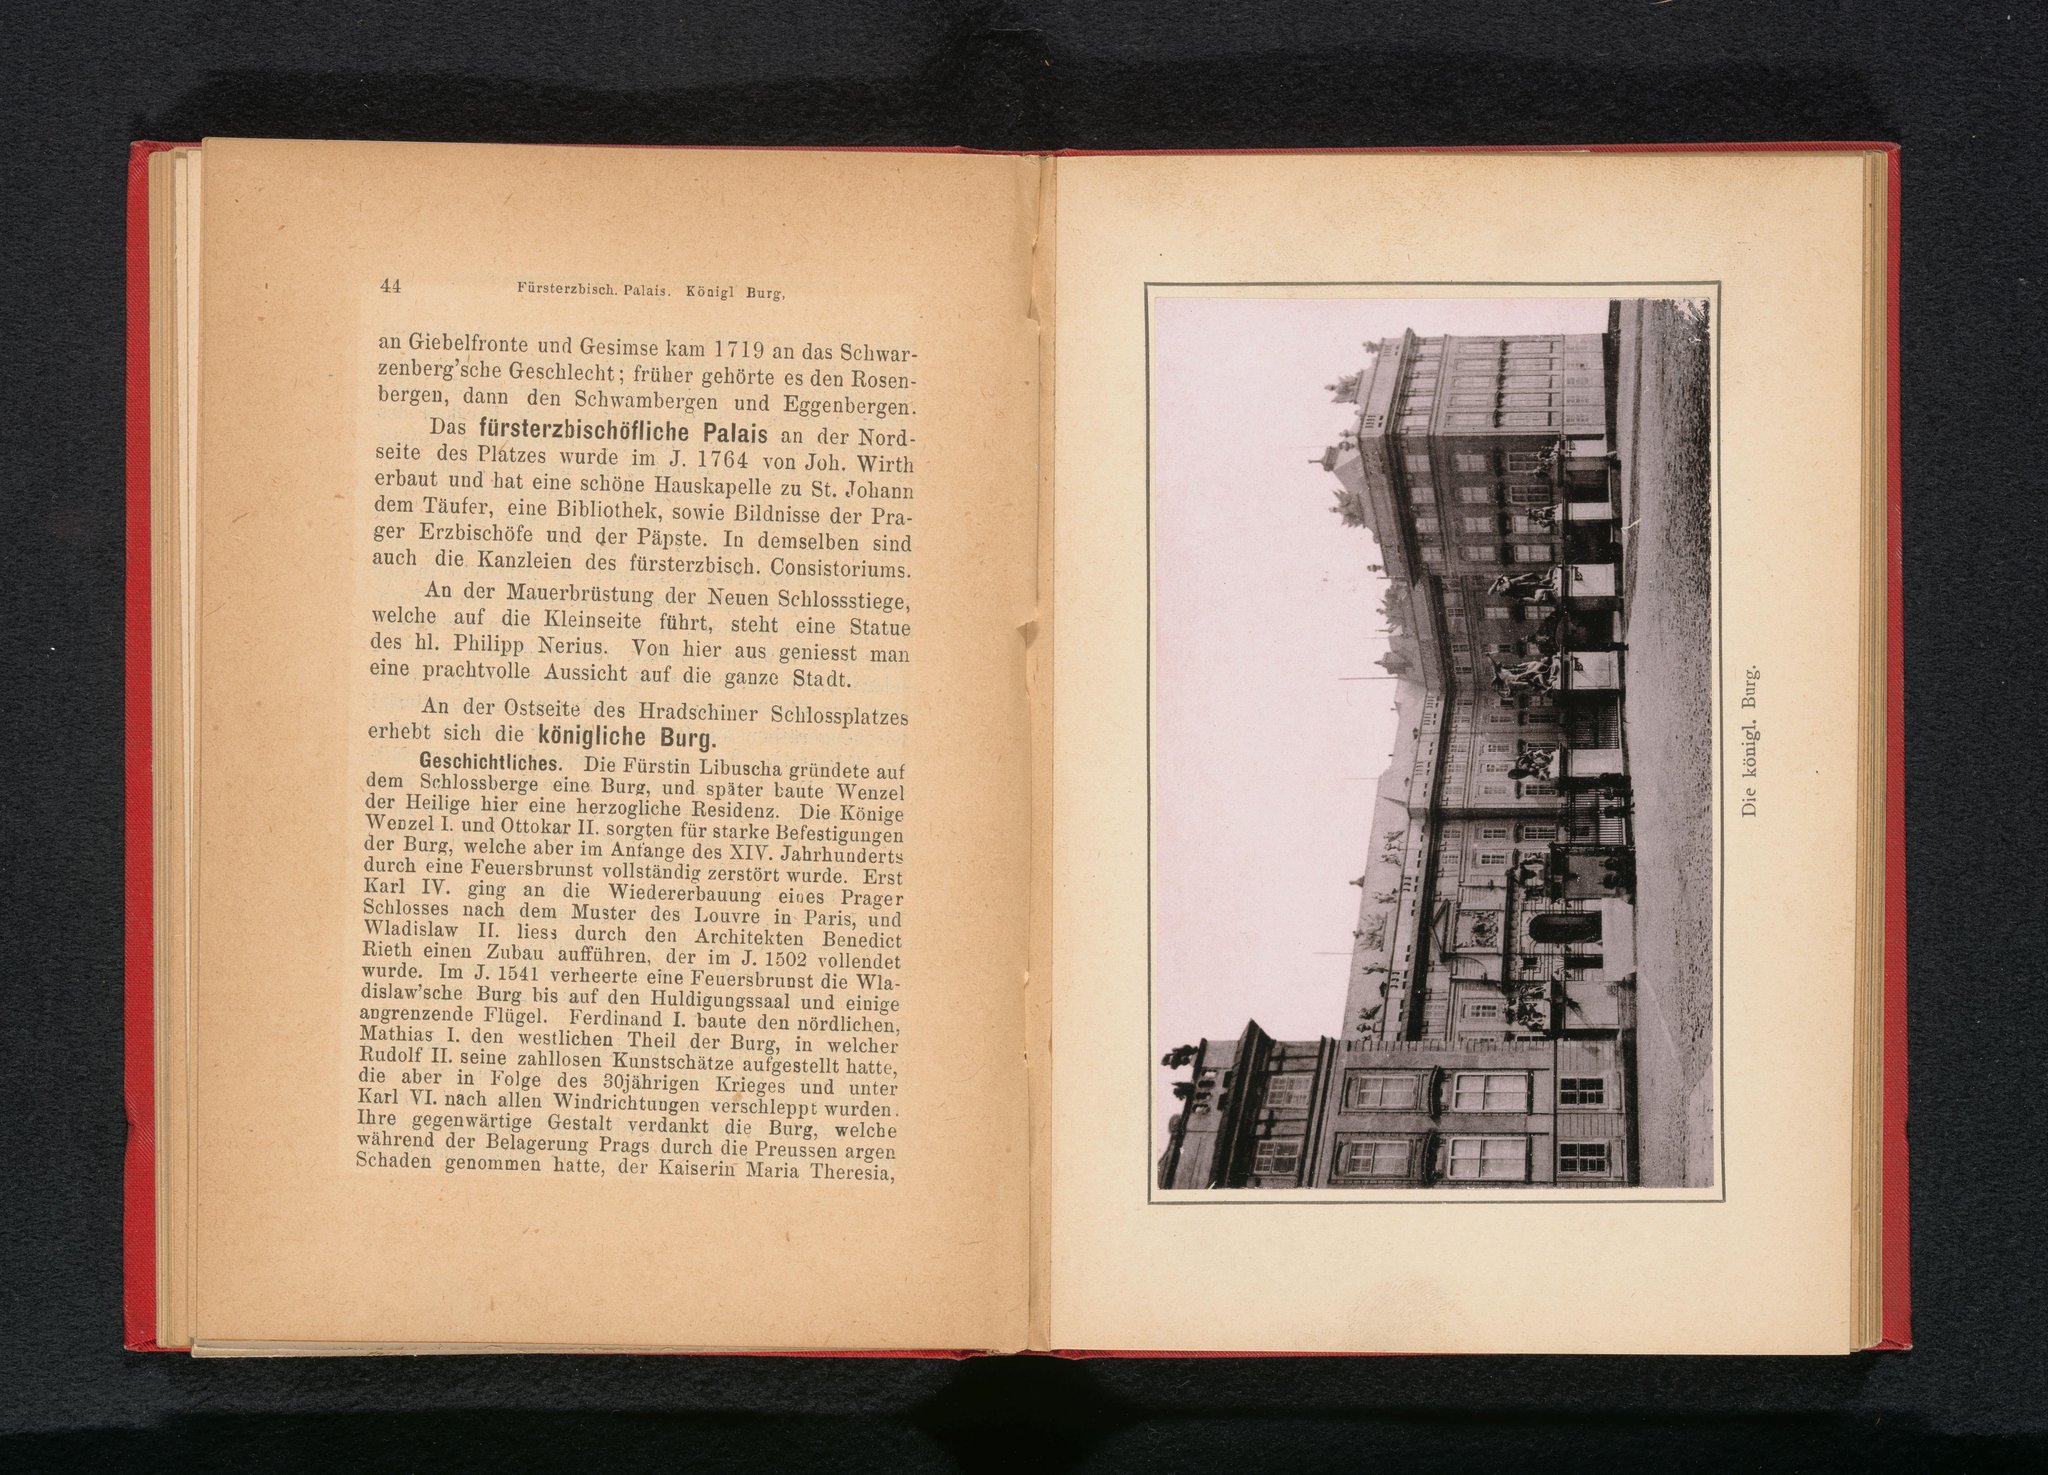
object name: photomechanical print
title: Exterieur van de Burcht van Praag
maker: Anonymous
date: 1885-1890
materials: paper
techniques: photograph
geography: prague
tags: castle, façade (of house or building)